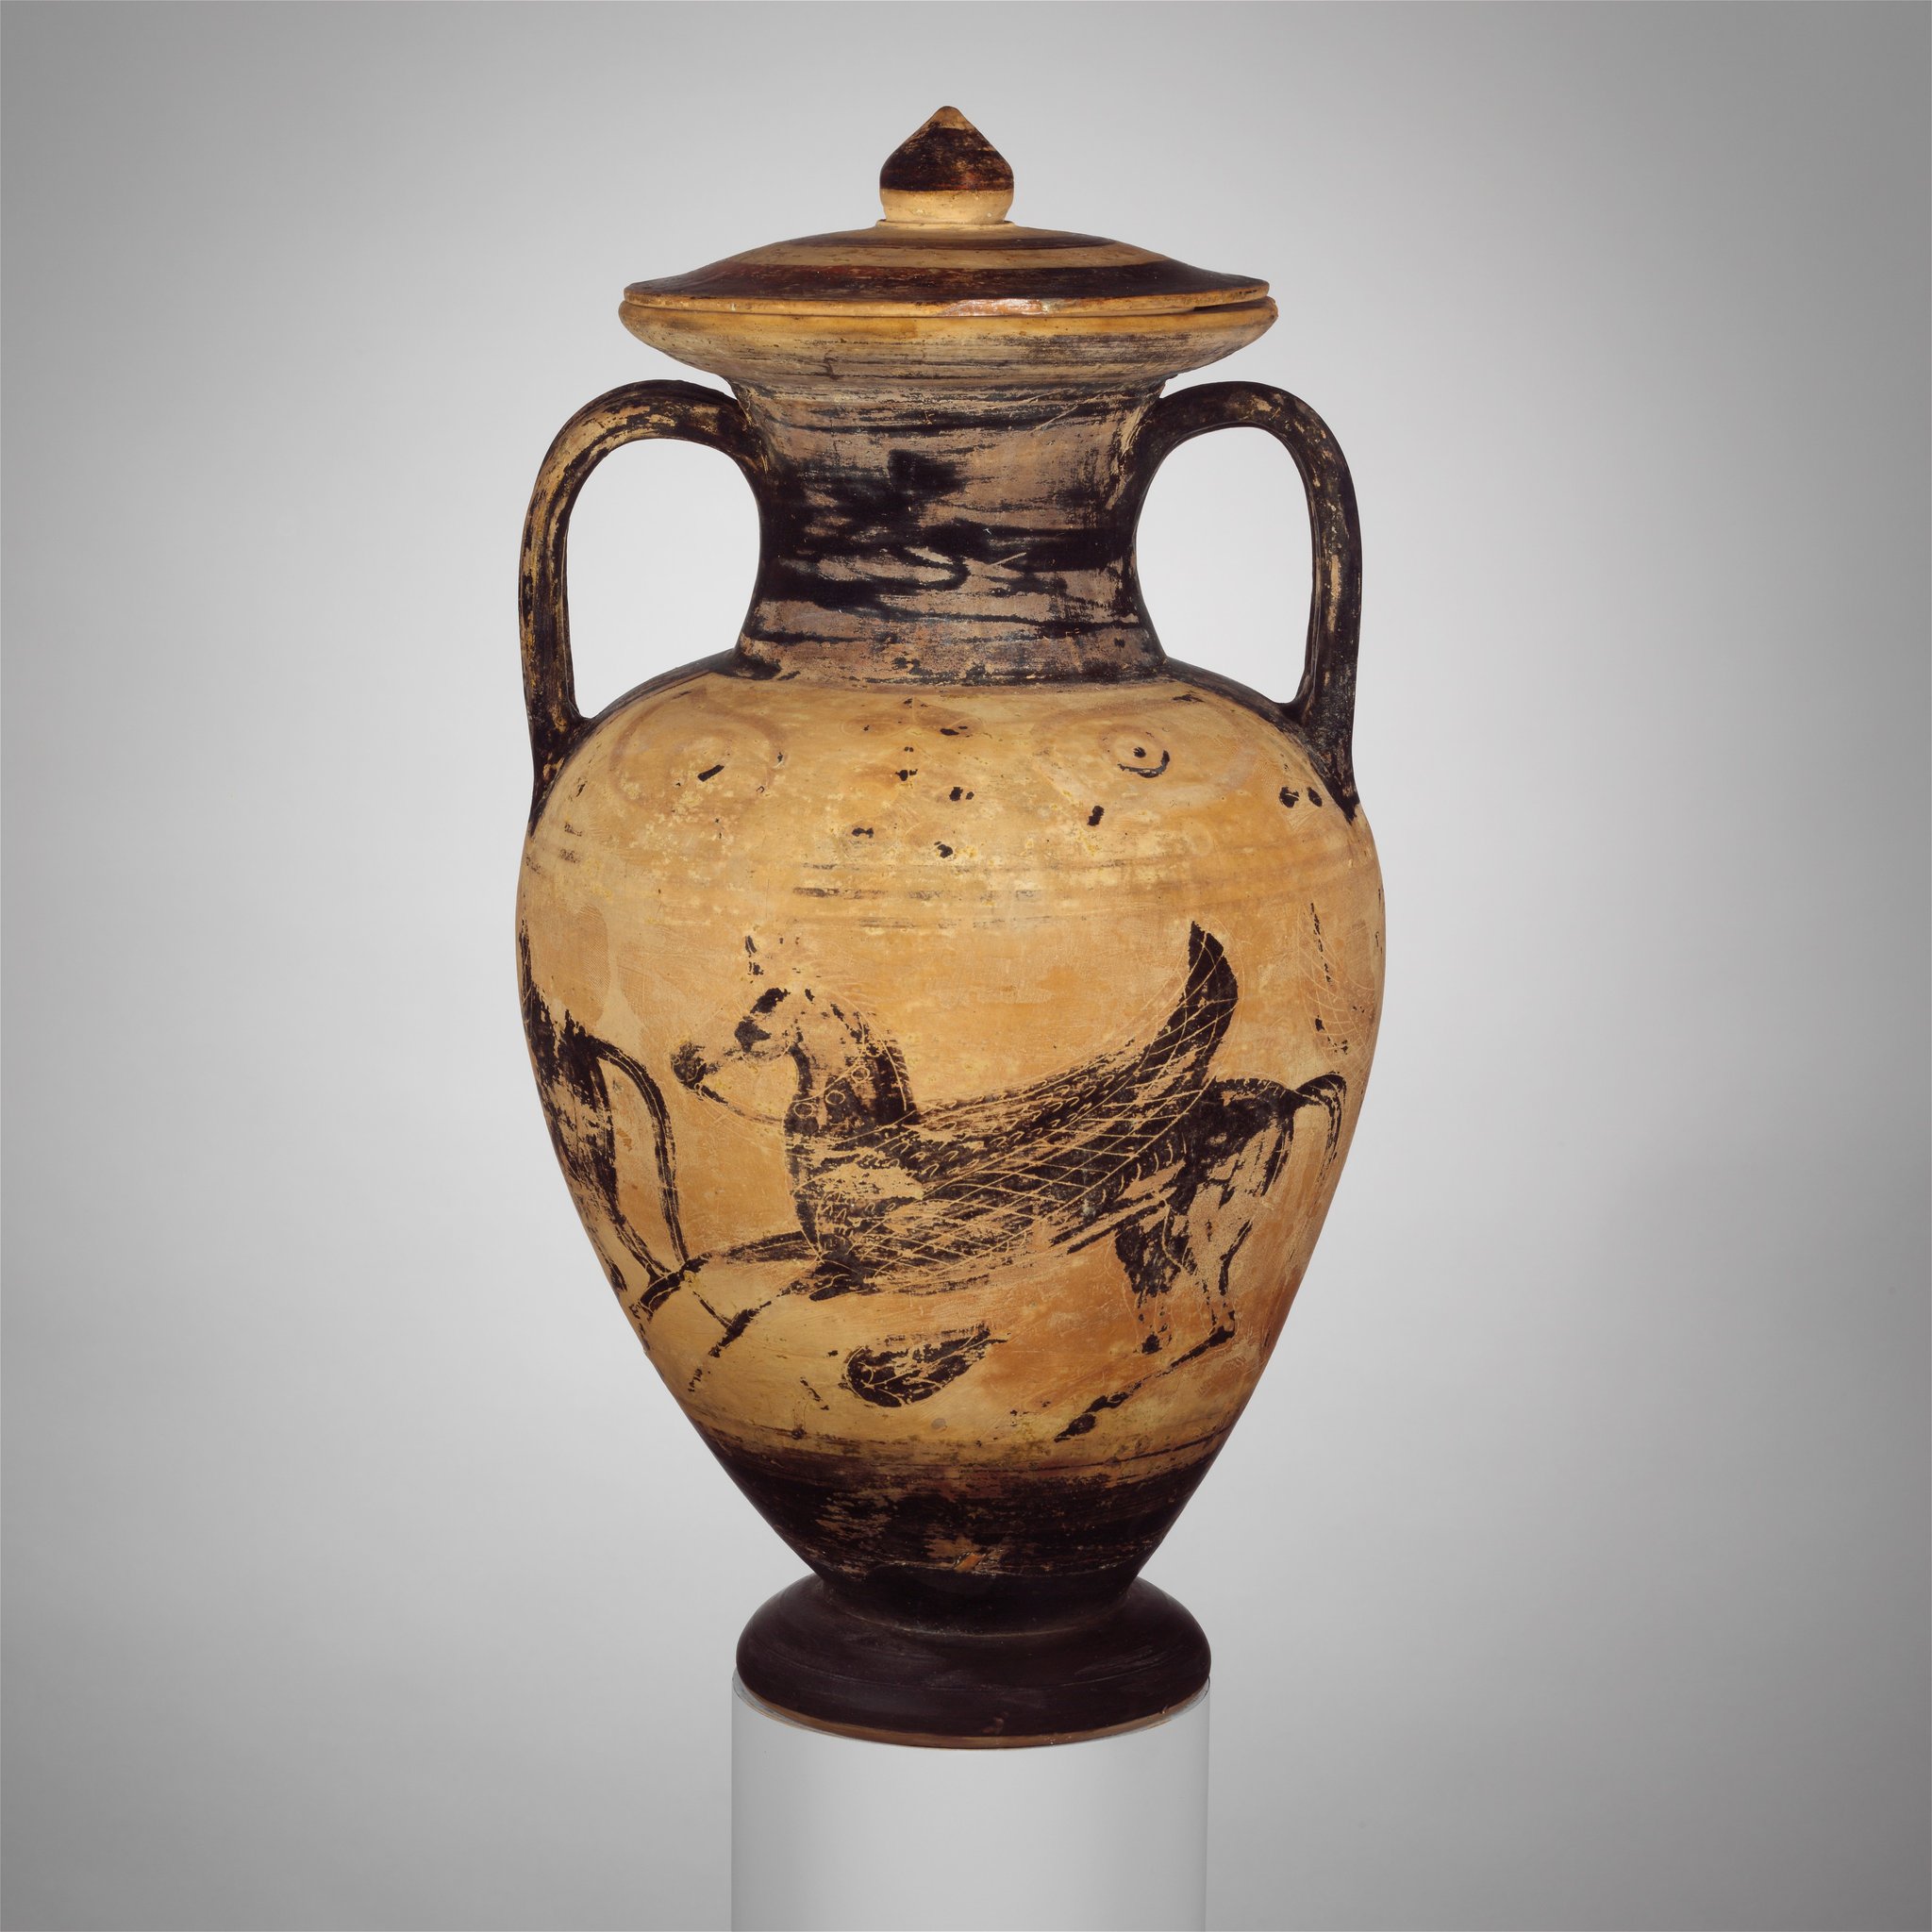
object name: neck amphora with lid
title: Terracotta neck-amphora (jar) with lid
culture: etruscan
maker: micali painter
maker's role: artist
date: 525-500 BCE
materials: terracotta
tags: horses